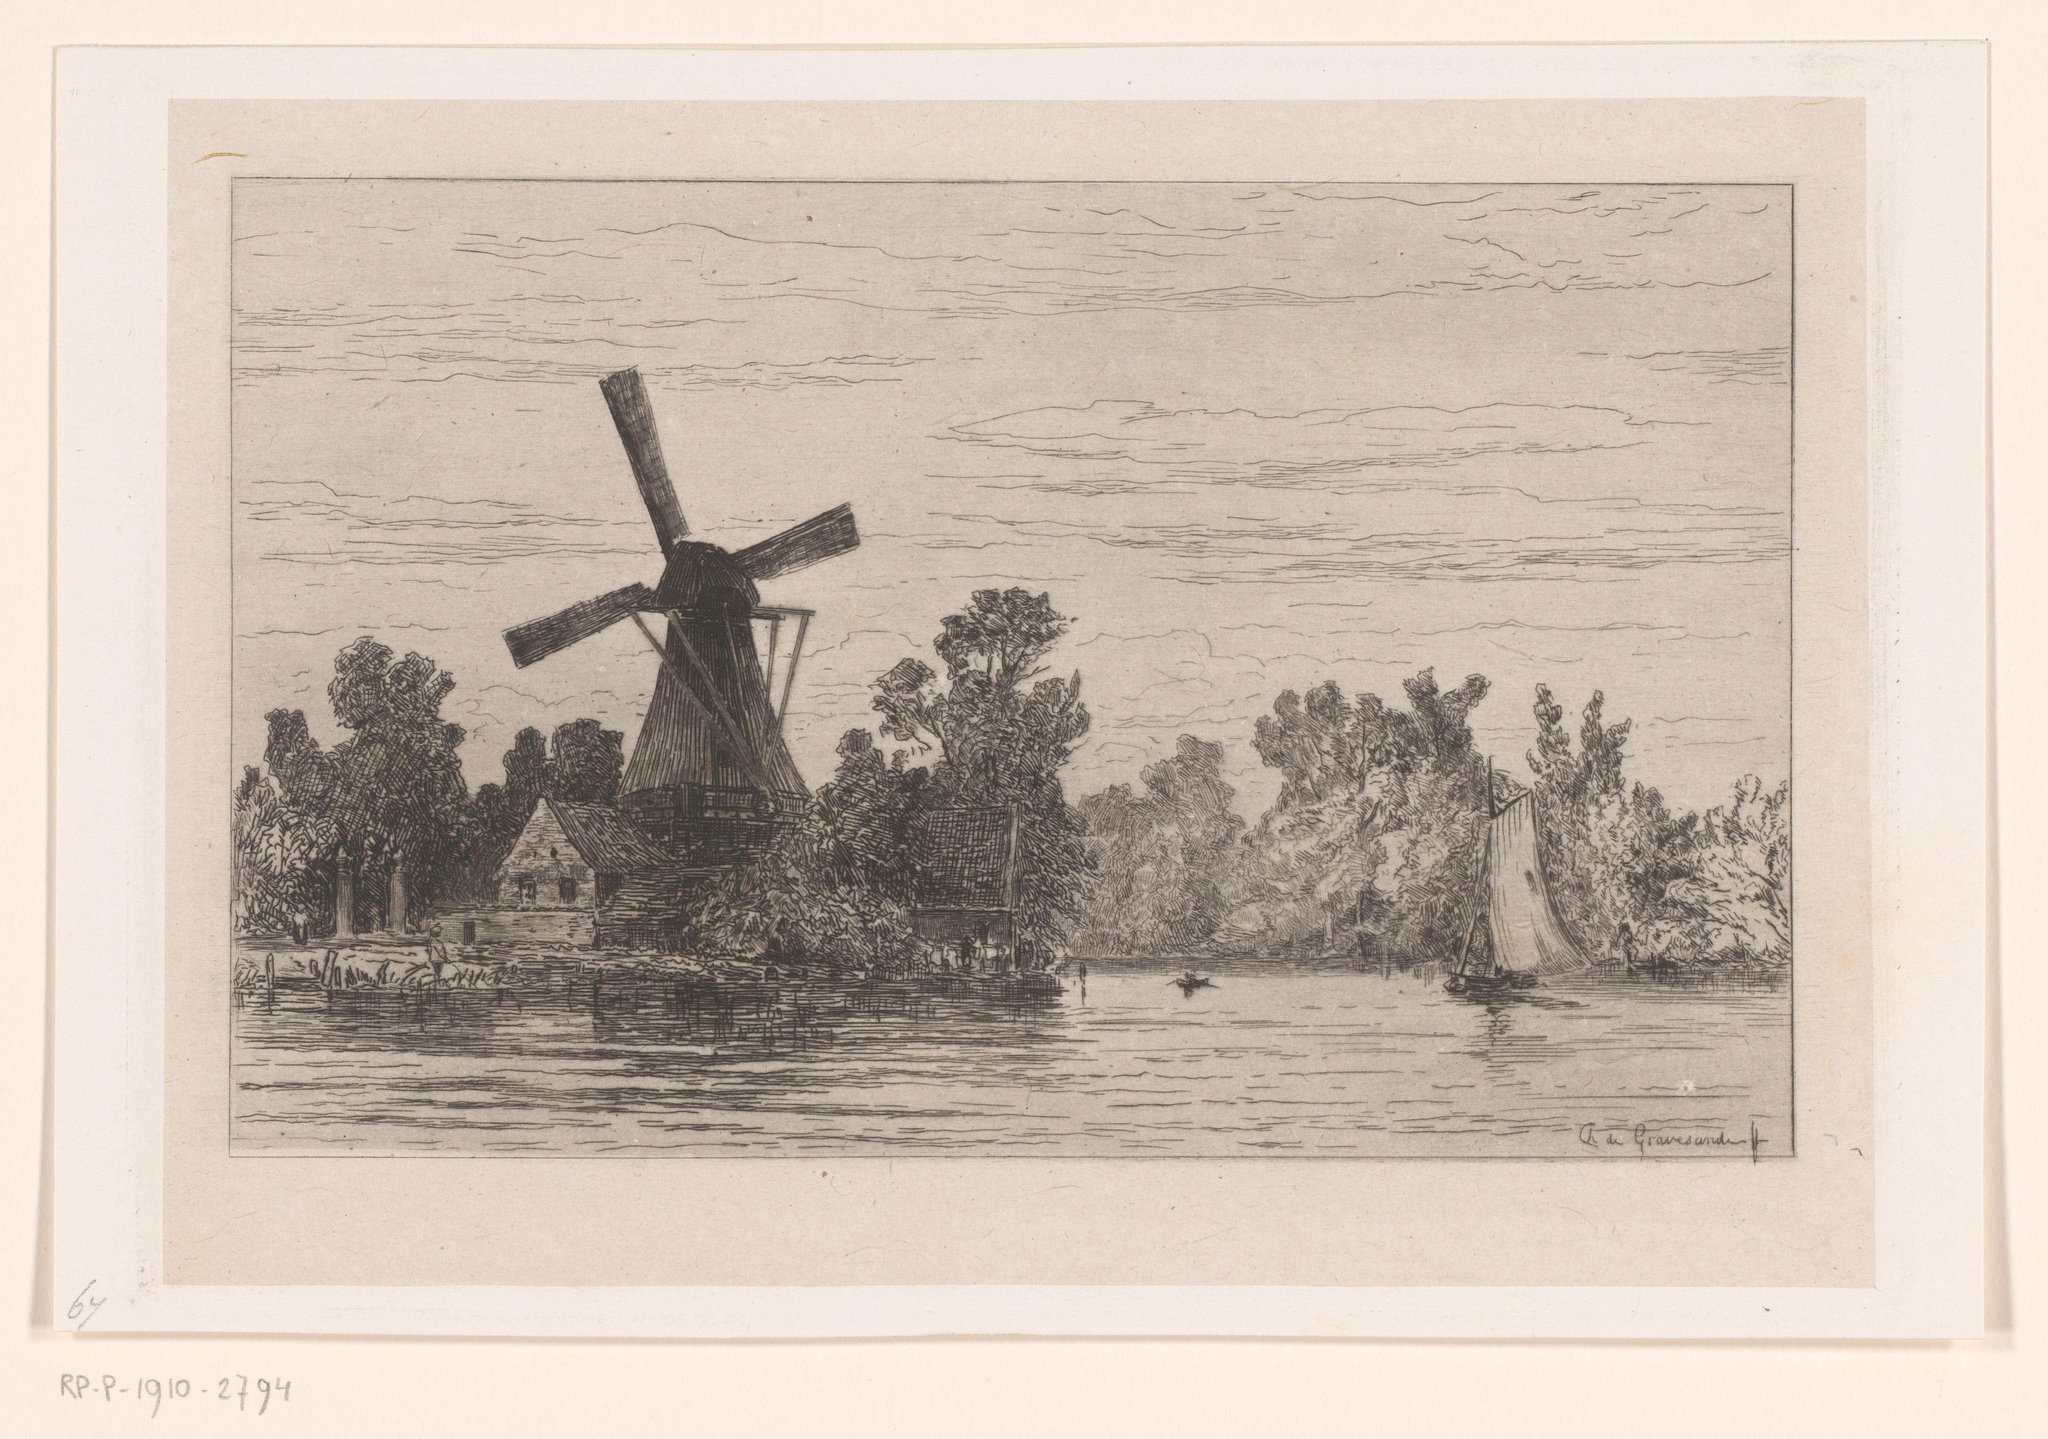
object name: print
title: Molen in Loenen aan de Vecht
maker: carel nicolaas storm van s-gravesande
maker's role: draughtsman, print maker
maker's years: 1841-1924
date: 1873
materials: paper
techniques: etching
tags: river, windmill in landscape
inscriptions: collector's mark: Lugt 2228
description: Gezicht op de Vecht met links op de oever een molen.